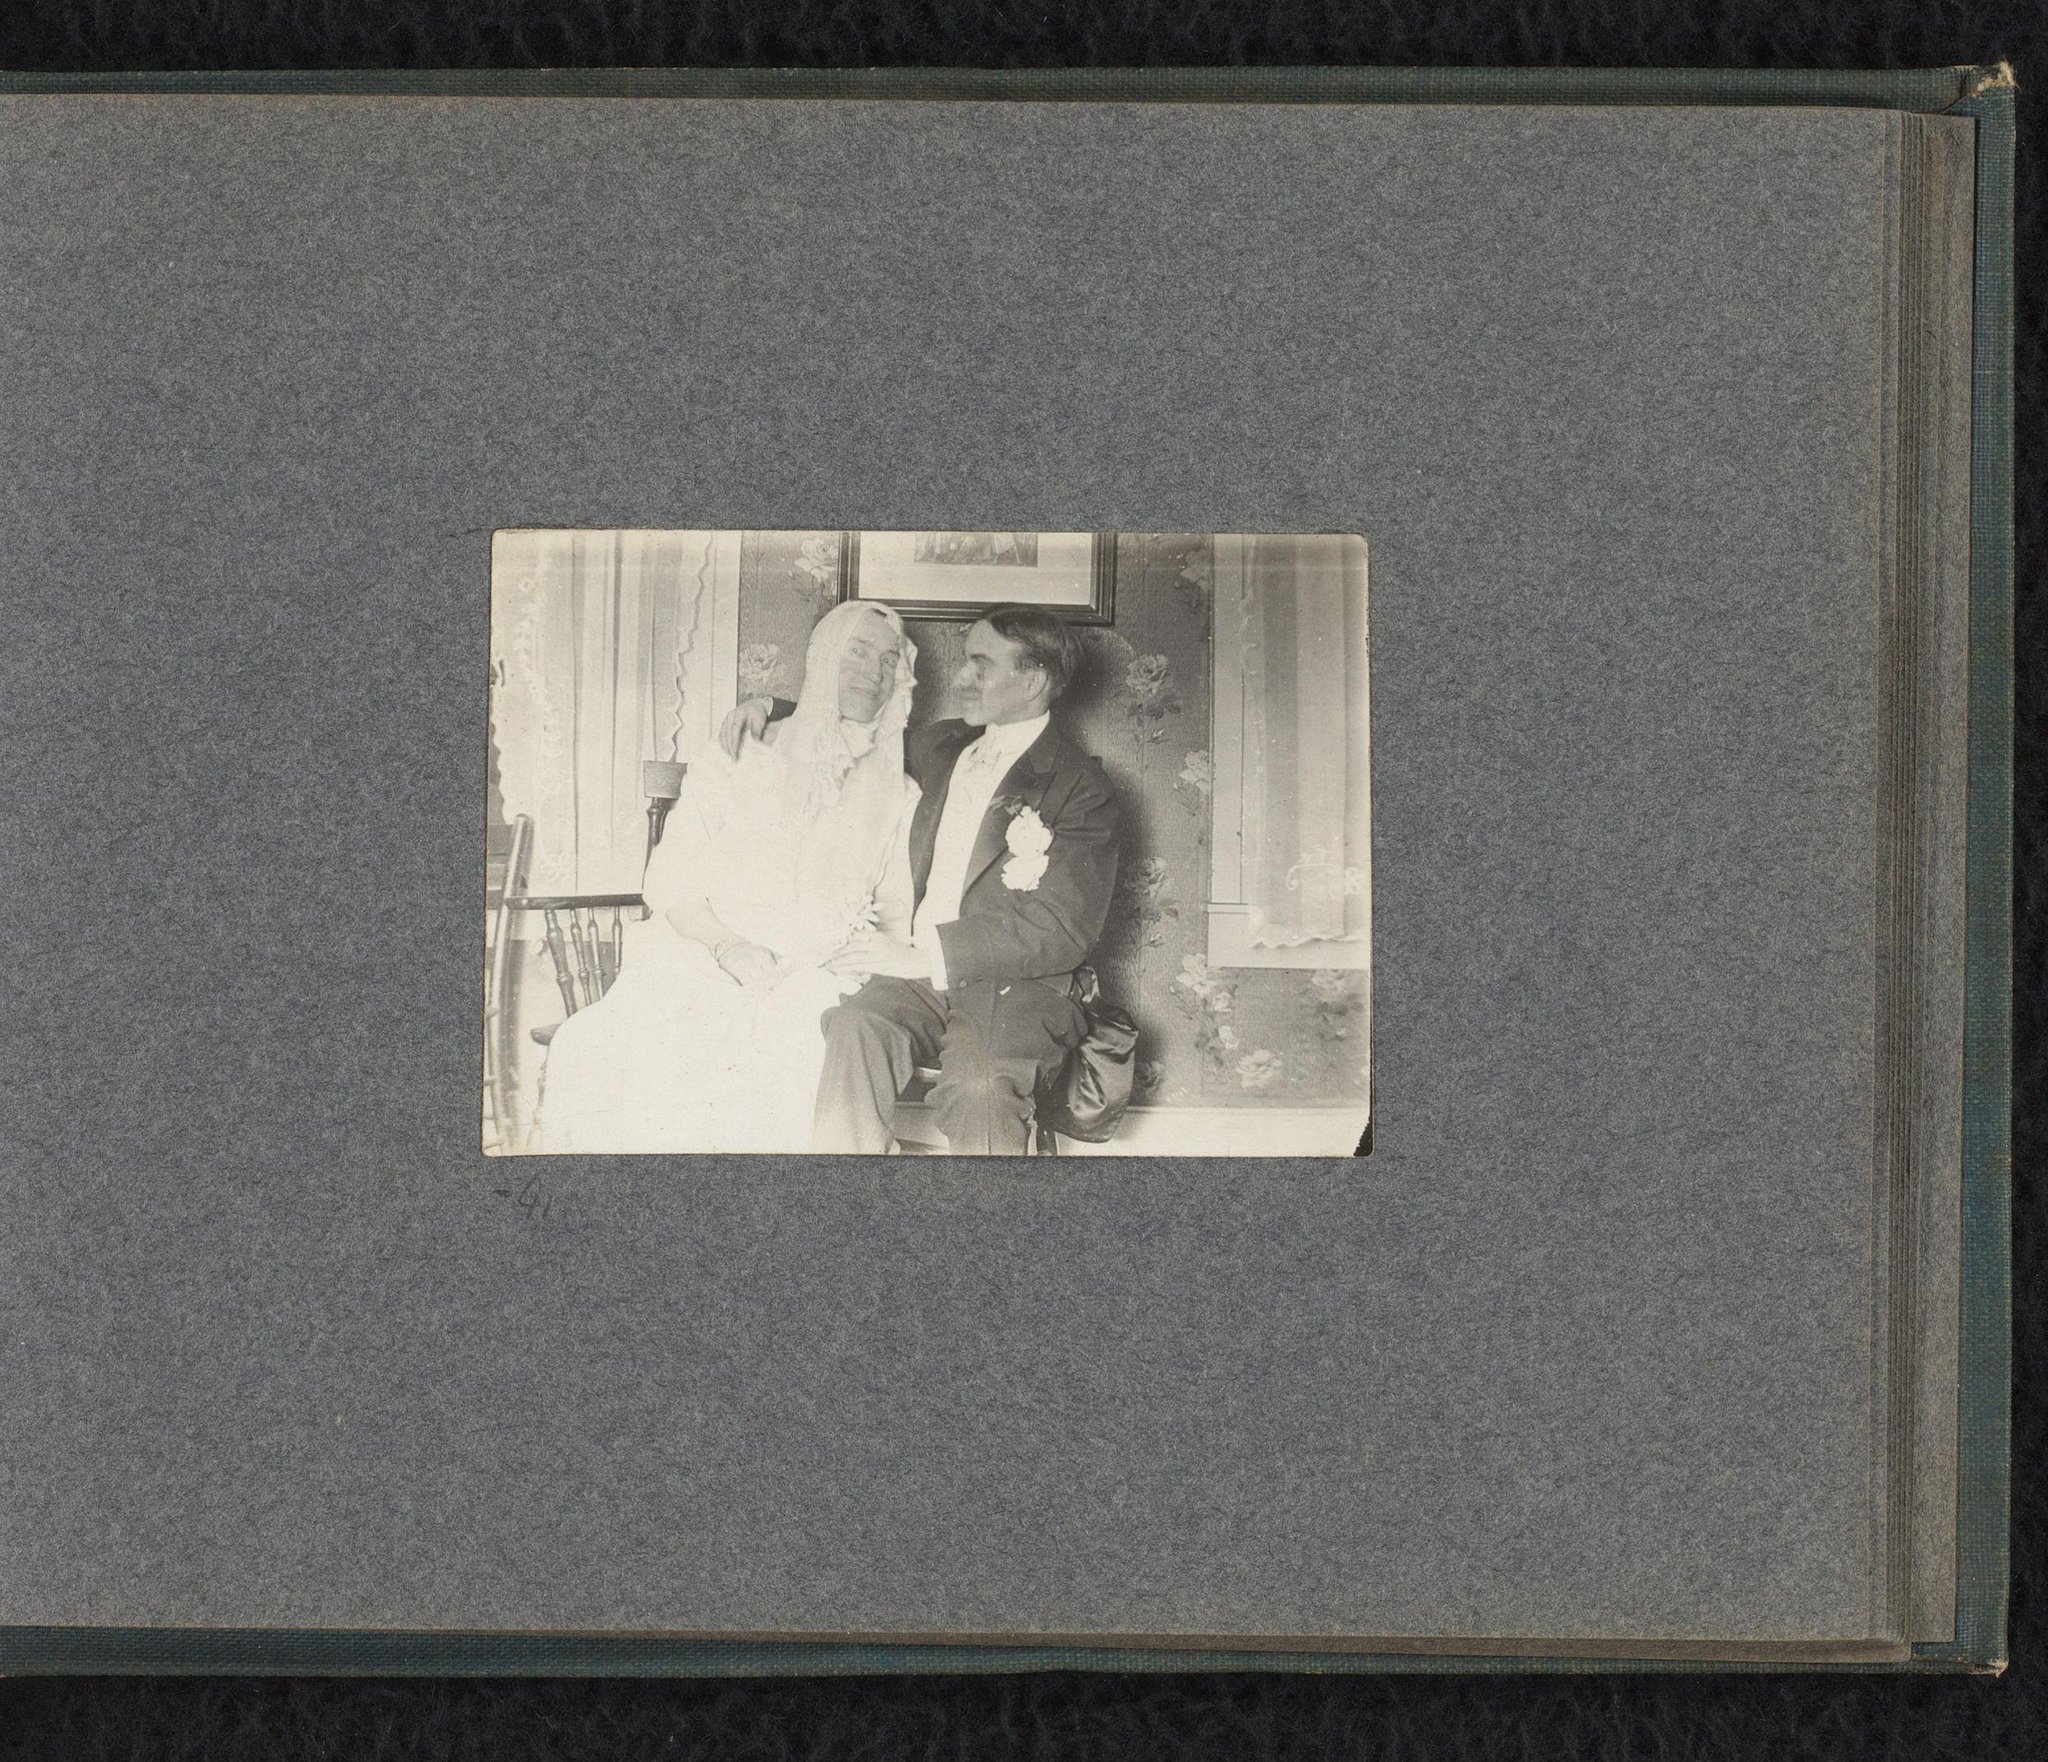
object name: photograph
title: Zittend bruidspaar, mogelijk twee mannelijke studenten tijdens een verkleedpartij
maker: Anonymous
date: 1910-1920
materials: paper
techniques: gelatin silver print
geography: united states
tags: bride and groom in wedding-dress, student, united states of america